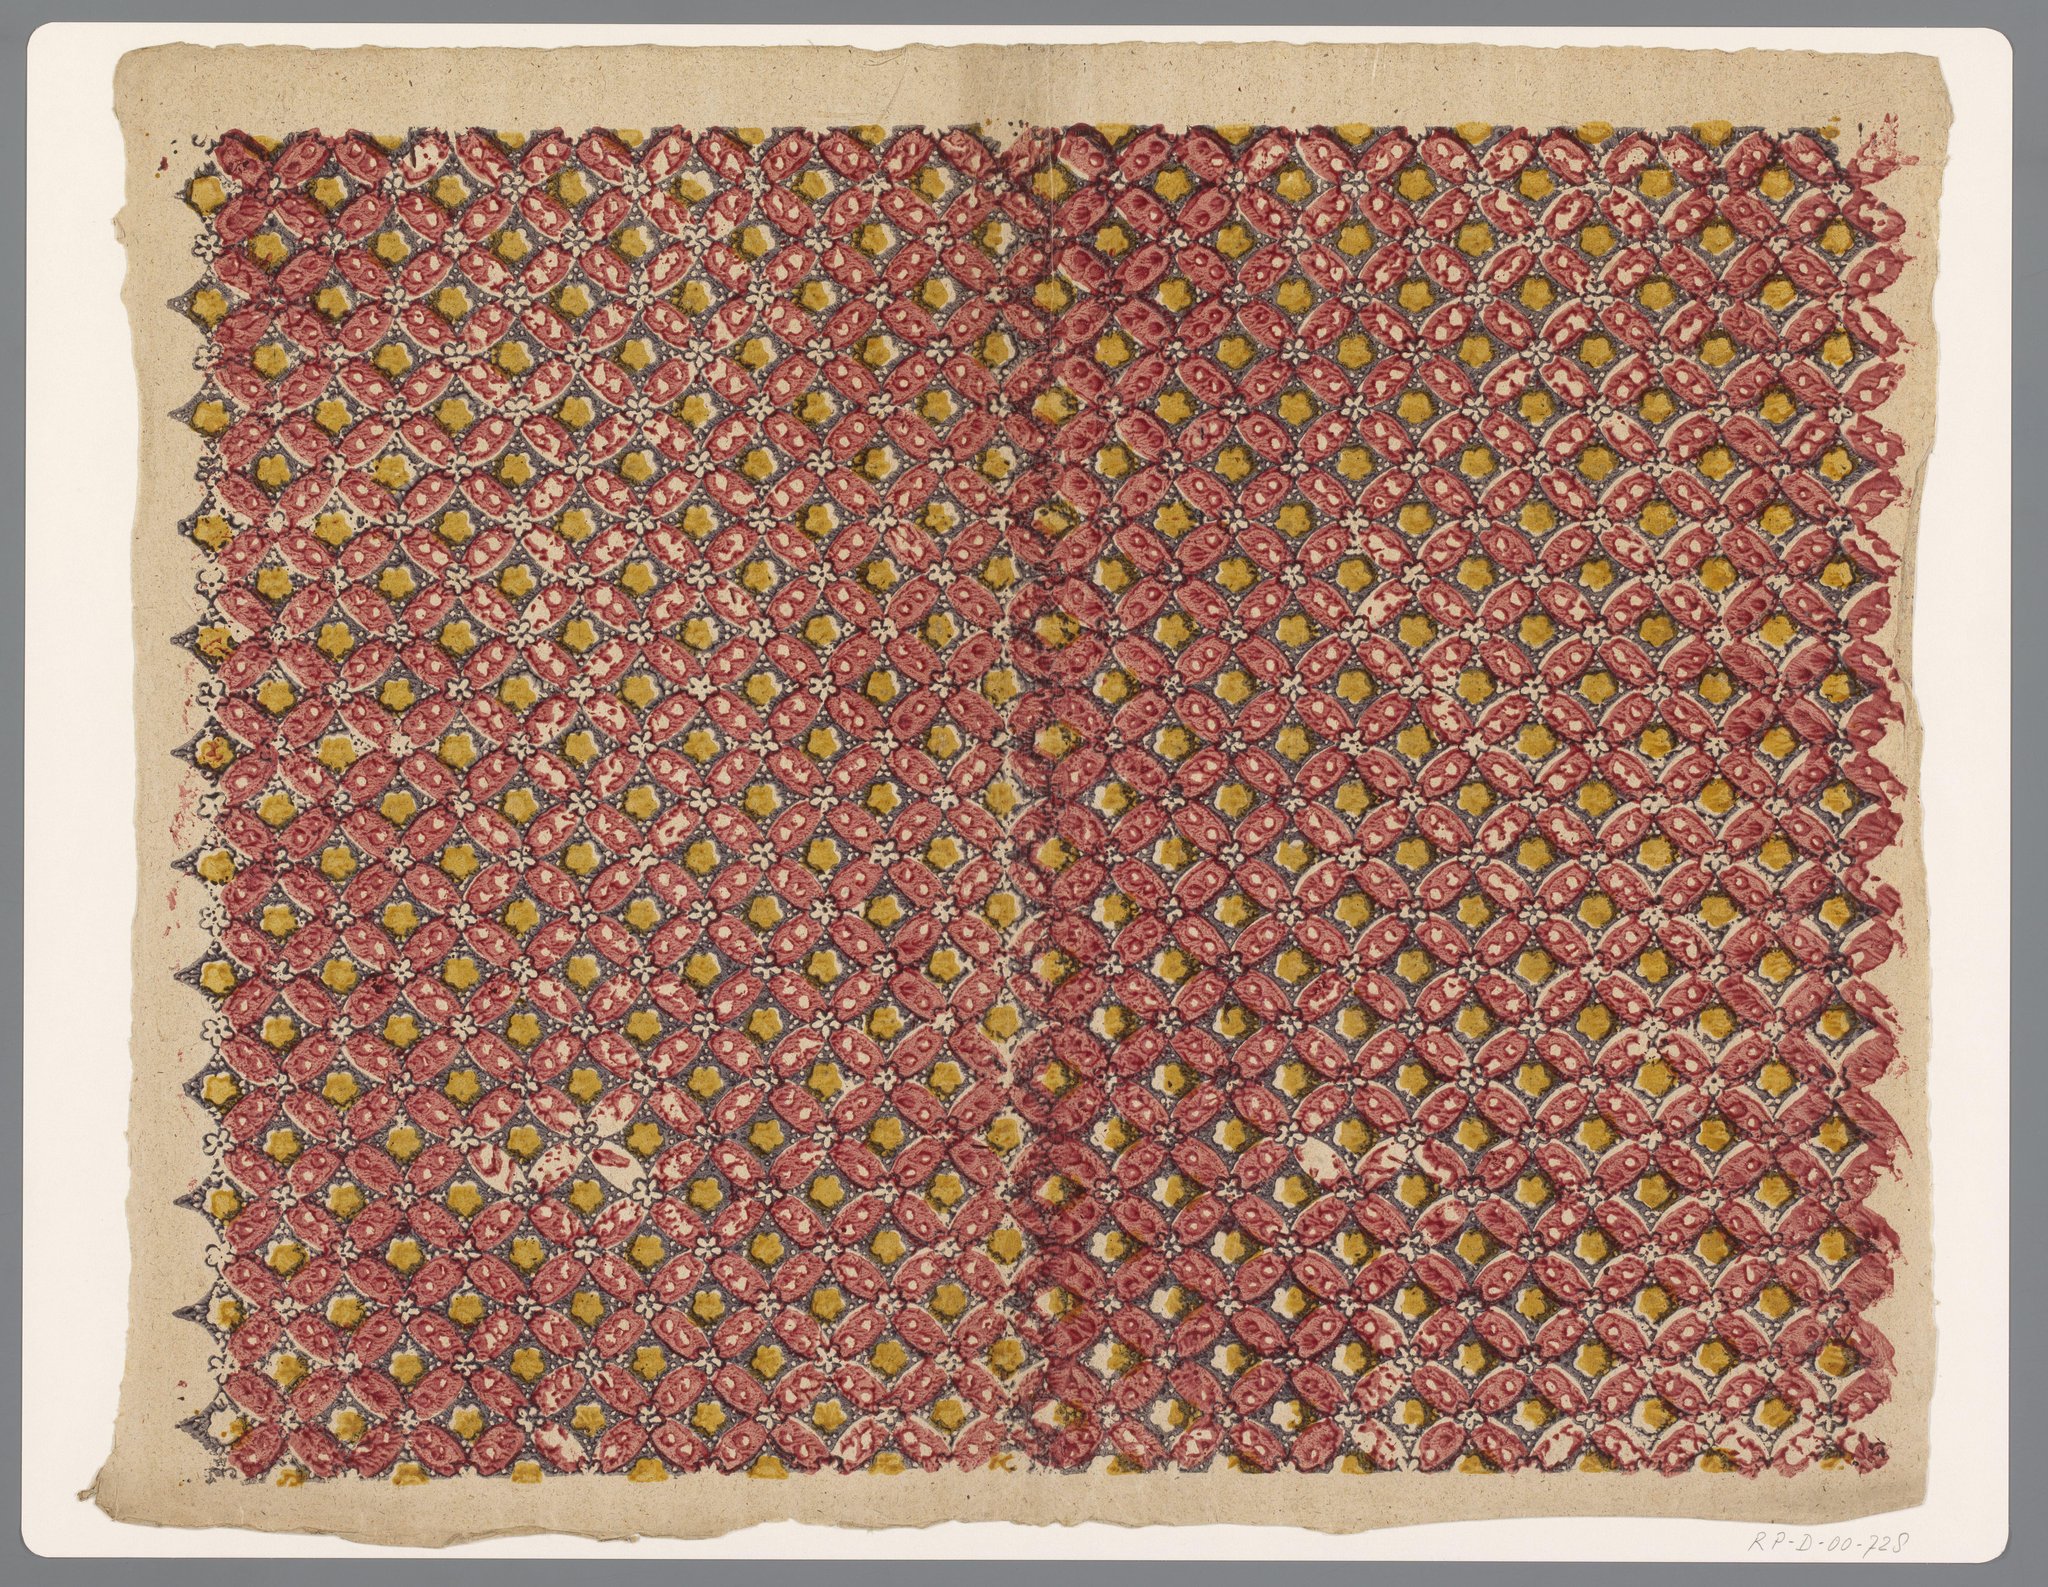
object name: printed paper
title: Blad met ruitenpatroon van bloemmotieven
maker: Anonymous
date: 1750-1900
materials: lacquer, paper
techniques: printing block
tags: ornament derived from plant forms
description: Blad met ruitenpatroon van bloemmotieven.